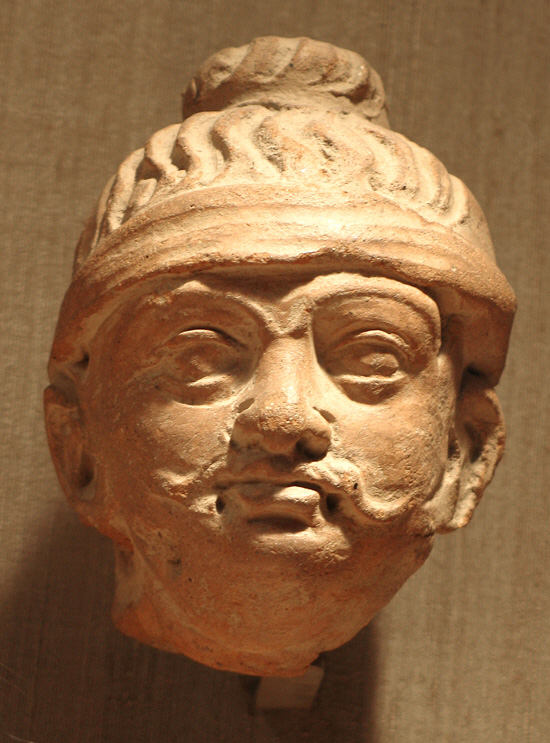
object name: head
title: Head of a Male Figure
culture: india, jammu and kashmir, akhnur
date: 501-700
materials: terracotta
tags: kashmir,faces,heads,men